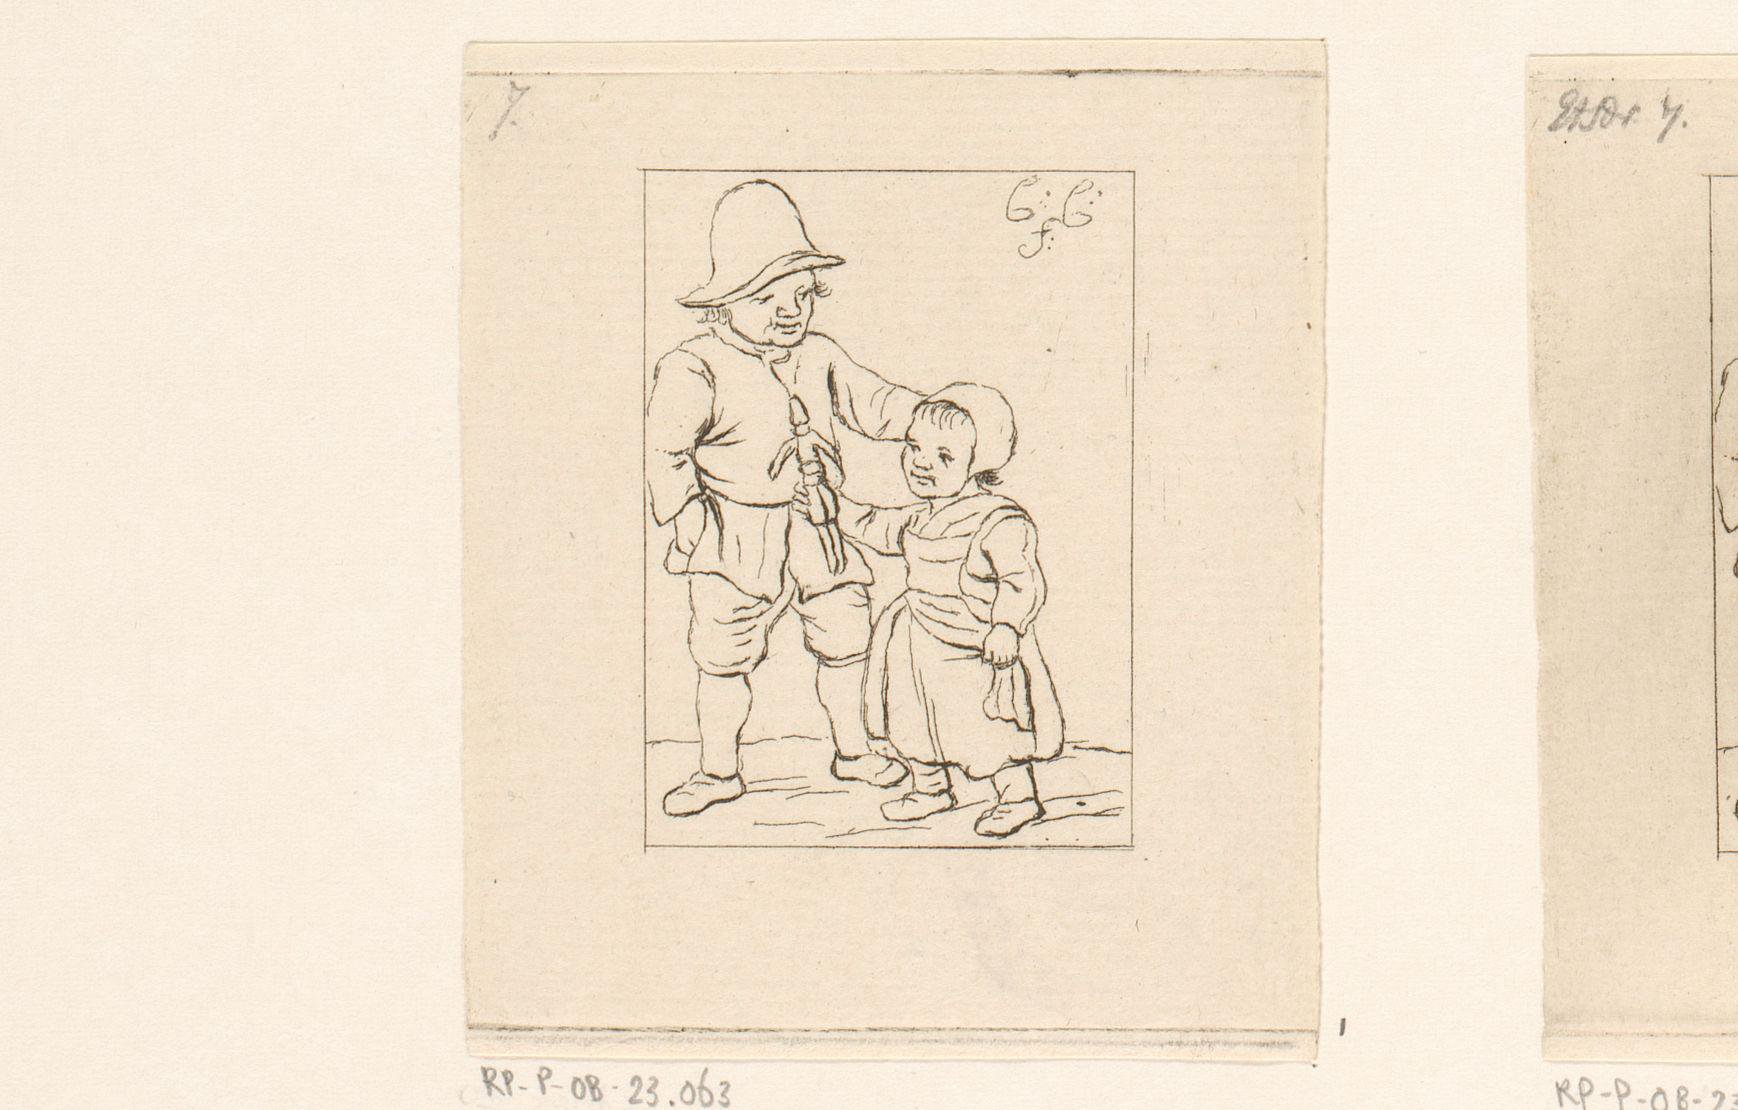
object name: print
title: Jongen en meisje met pop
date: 1779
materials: paper, pencil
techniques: etching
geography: leiden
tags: children's games and plays, (playing with) dolls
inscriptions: collector's mark: Lugt 240, number: ‘7’